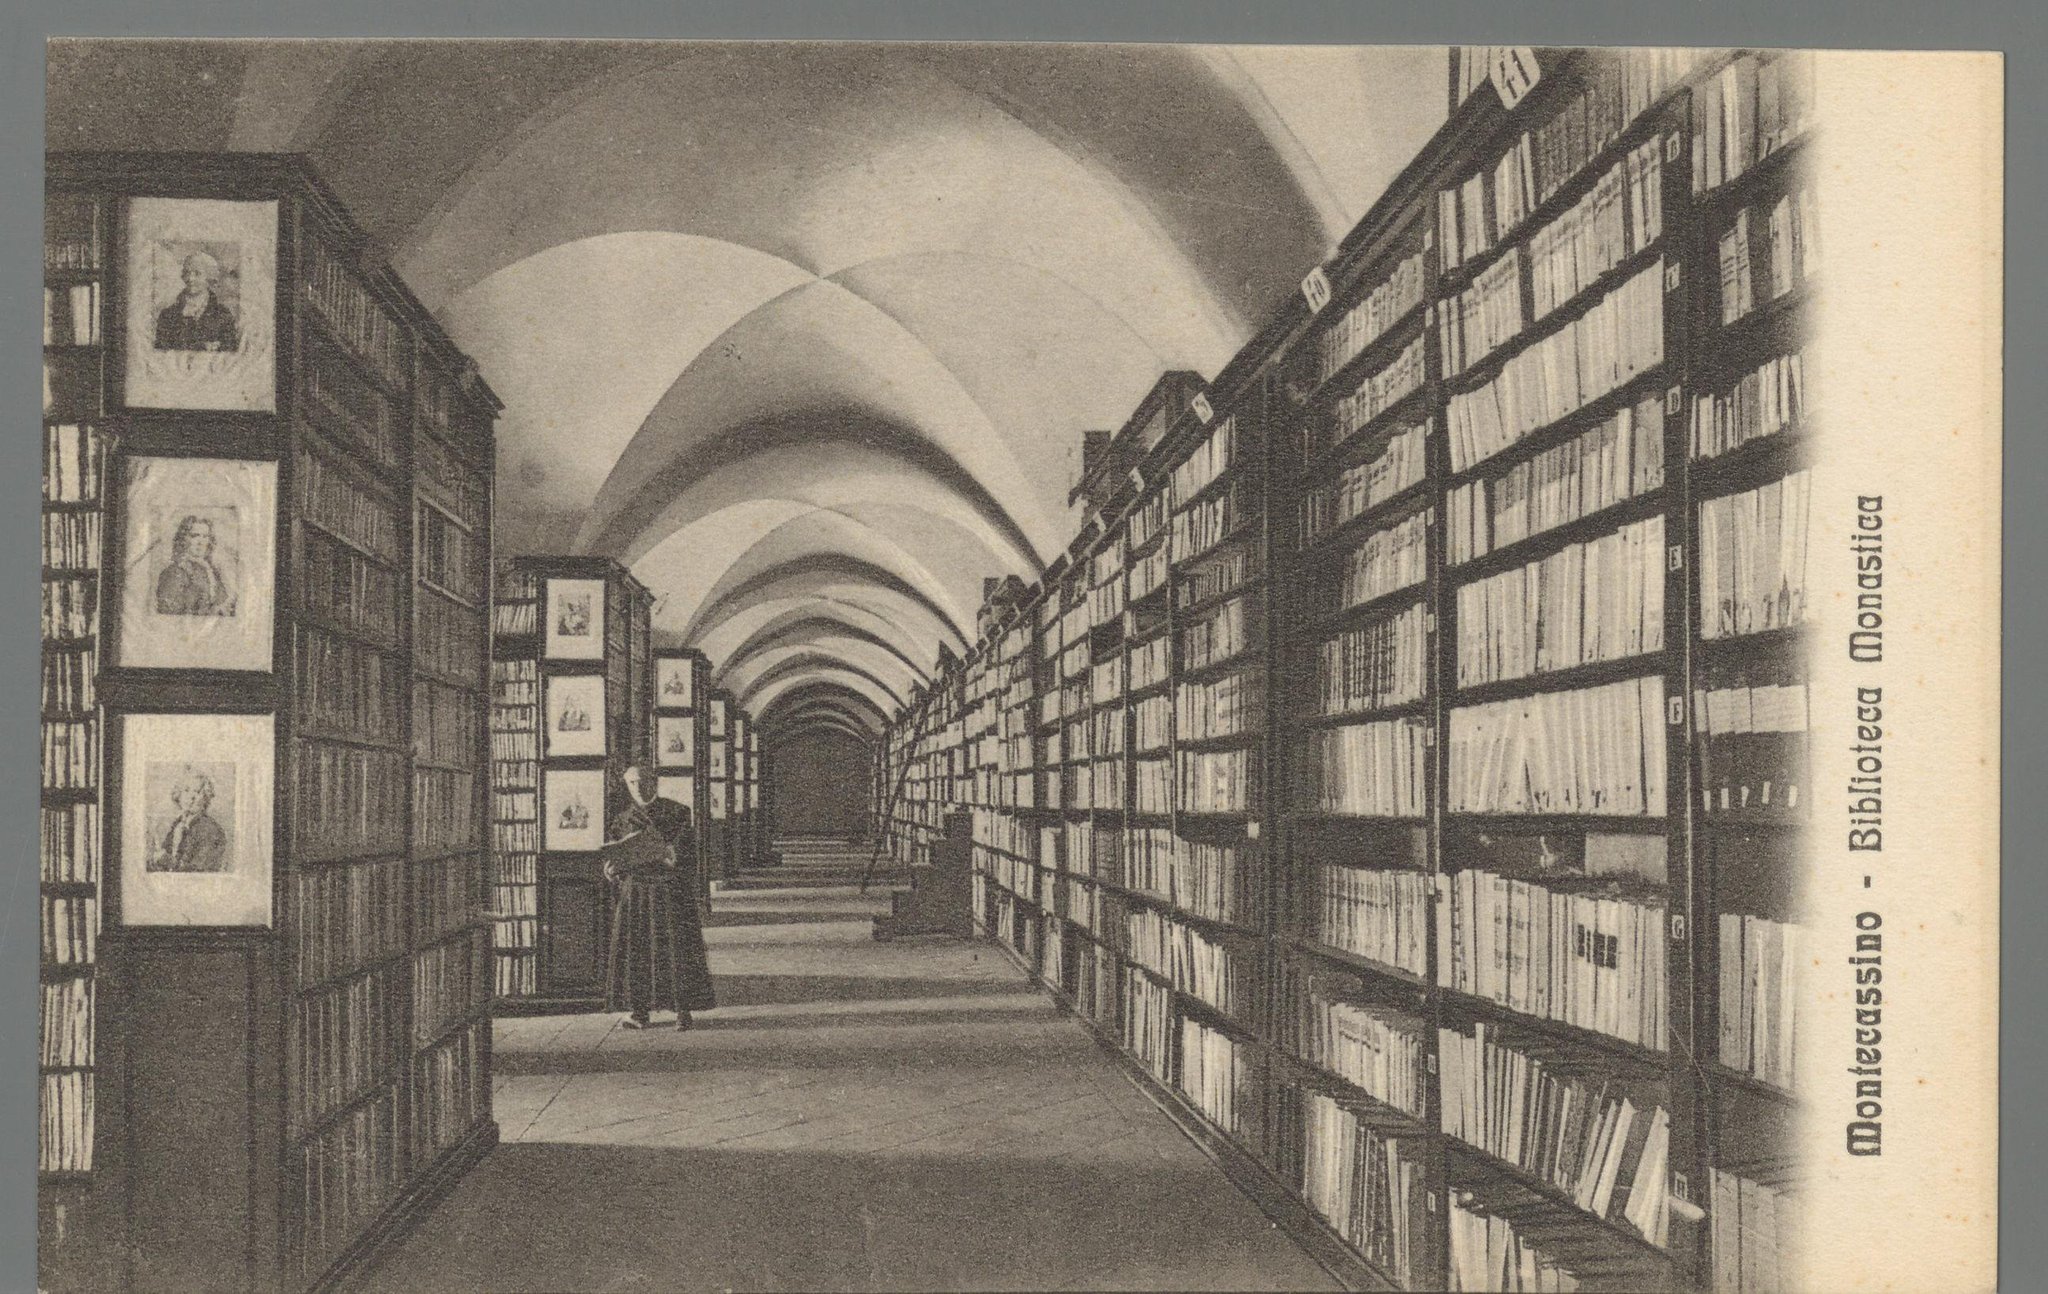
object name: photomechanical print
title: Montecassino. Biblioteca Monastica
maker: Anonymous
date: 1906-1910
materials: cardboard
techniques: photograph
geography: terni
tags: abbey, monastery, convent ~ roman catholic church, study; 'studiolo'; library